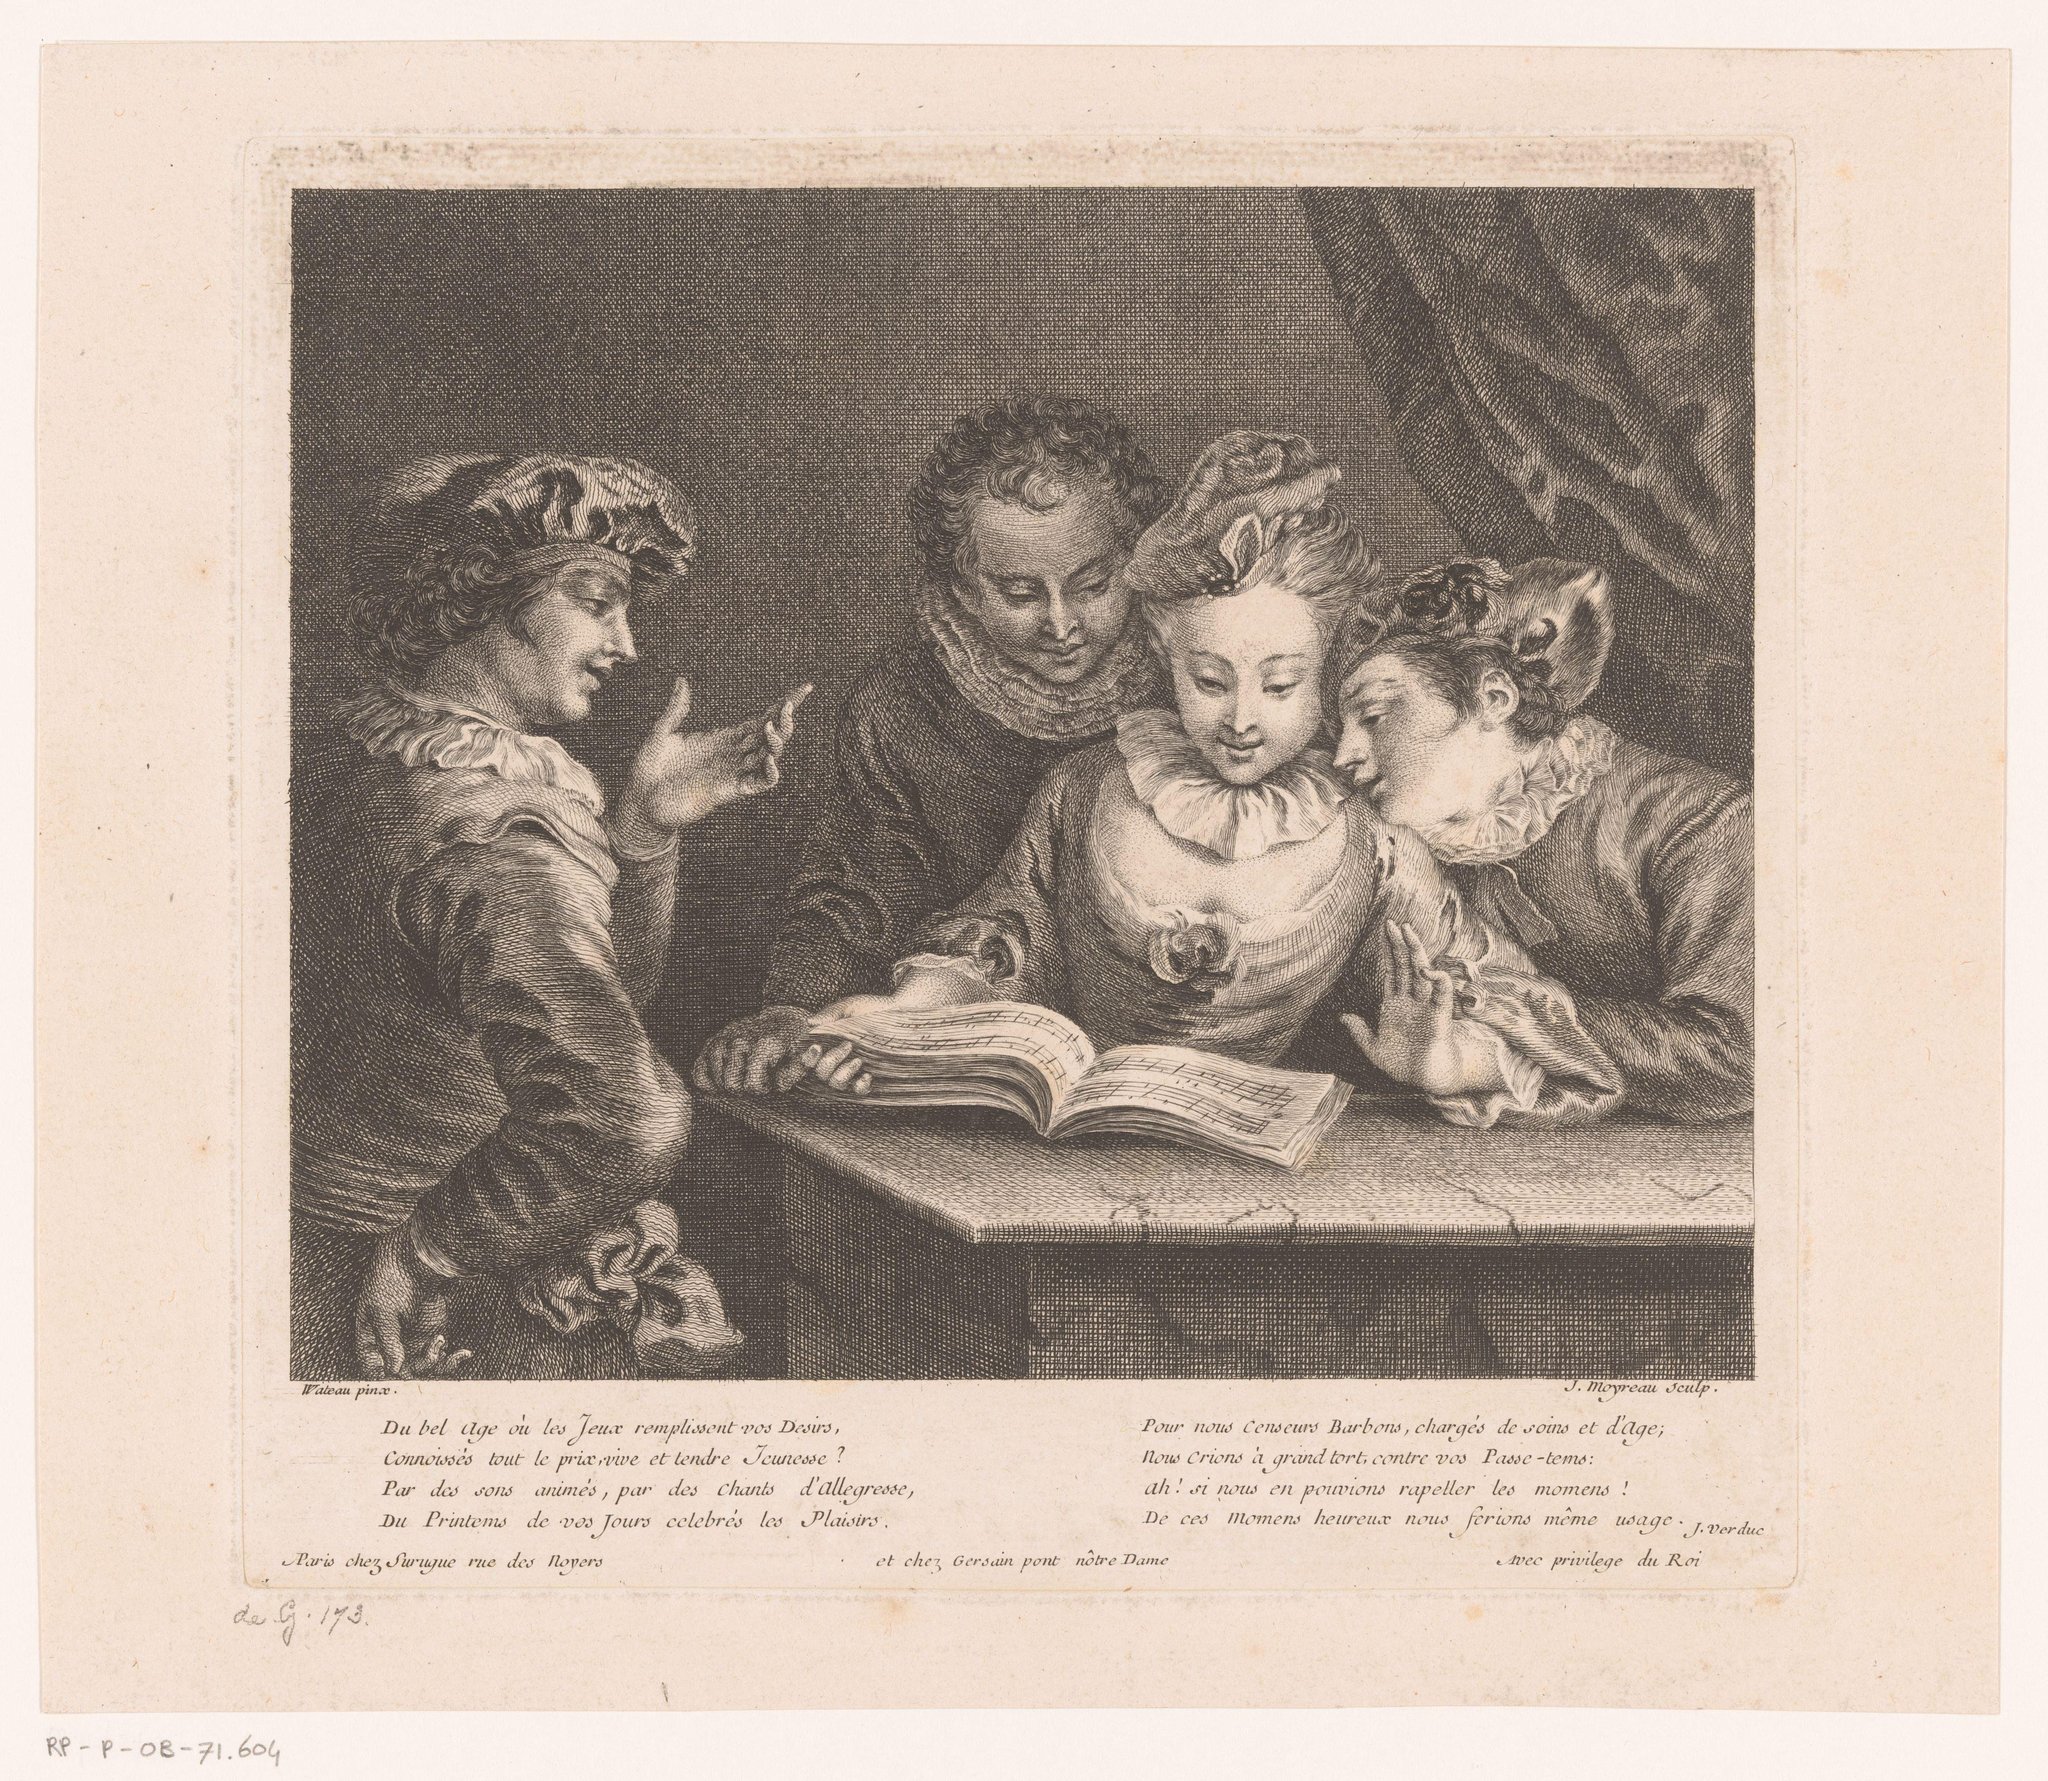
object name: print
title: Oeuvre van Antoine Watteau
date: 1726-1735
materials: paper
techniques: engraving, etching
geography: paris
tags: vocal music, singing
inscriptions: collector's mark: Lugt 2228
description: Maakt deel uit van een serie van 271 platen naar schilderijen door Watteau, verdeeld over drie delen, gecoördineerd door Jean de Jullienne en uitgegeven in Parijs tussen 1726 en 1735. Sommige platen werden reeds tijdens Watteau's leven gemaakt. Dit betreft plaat 93.